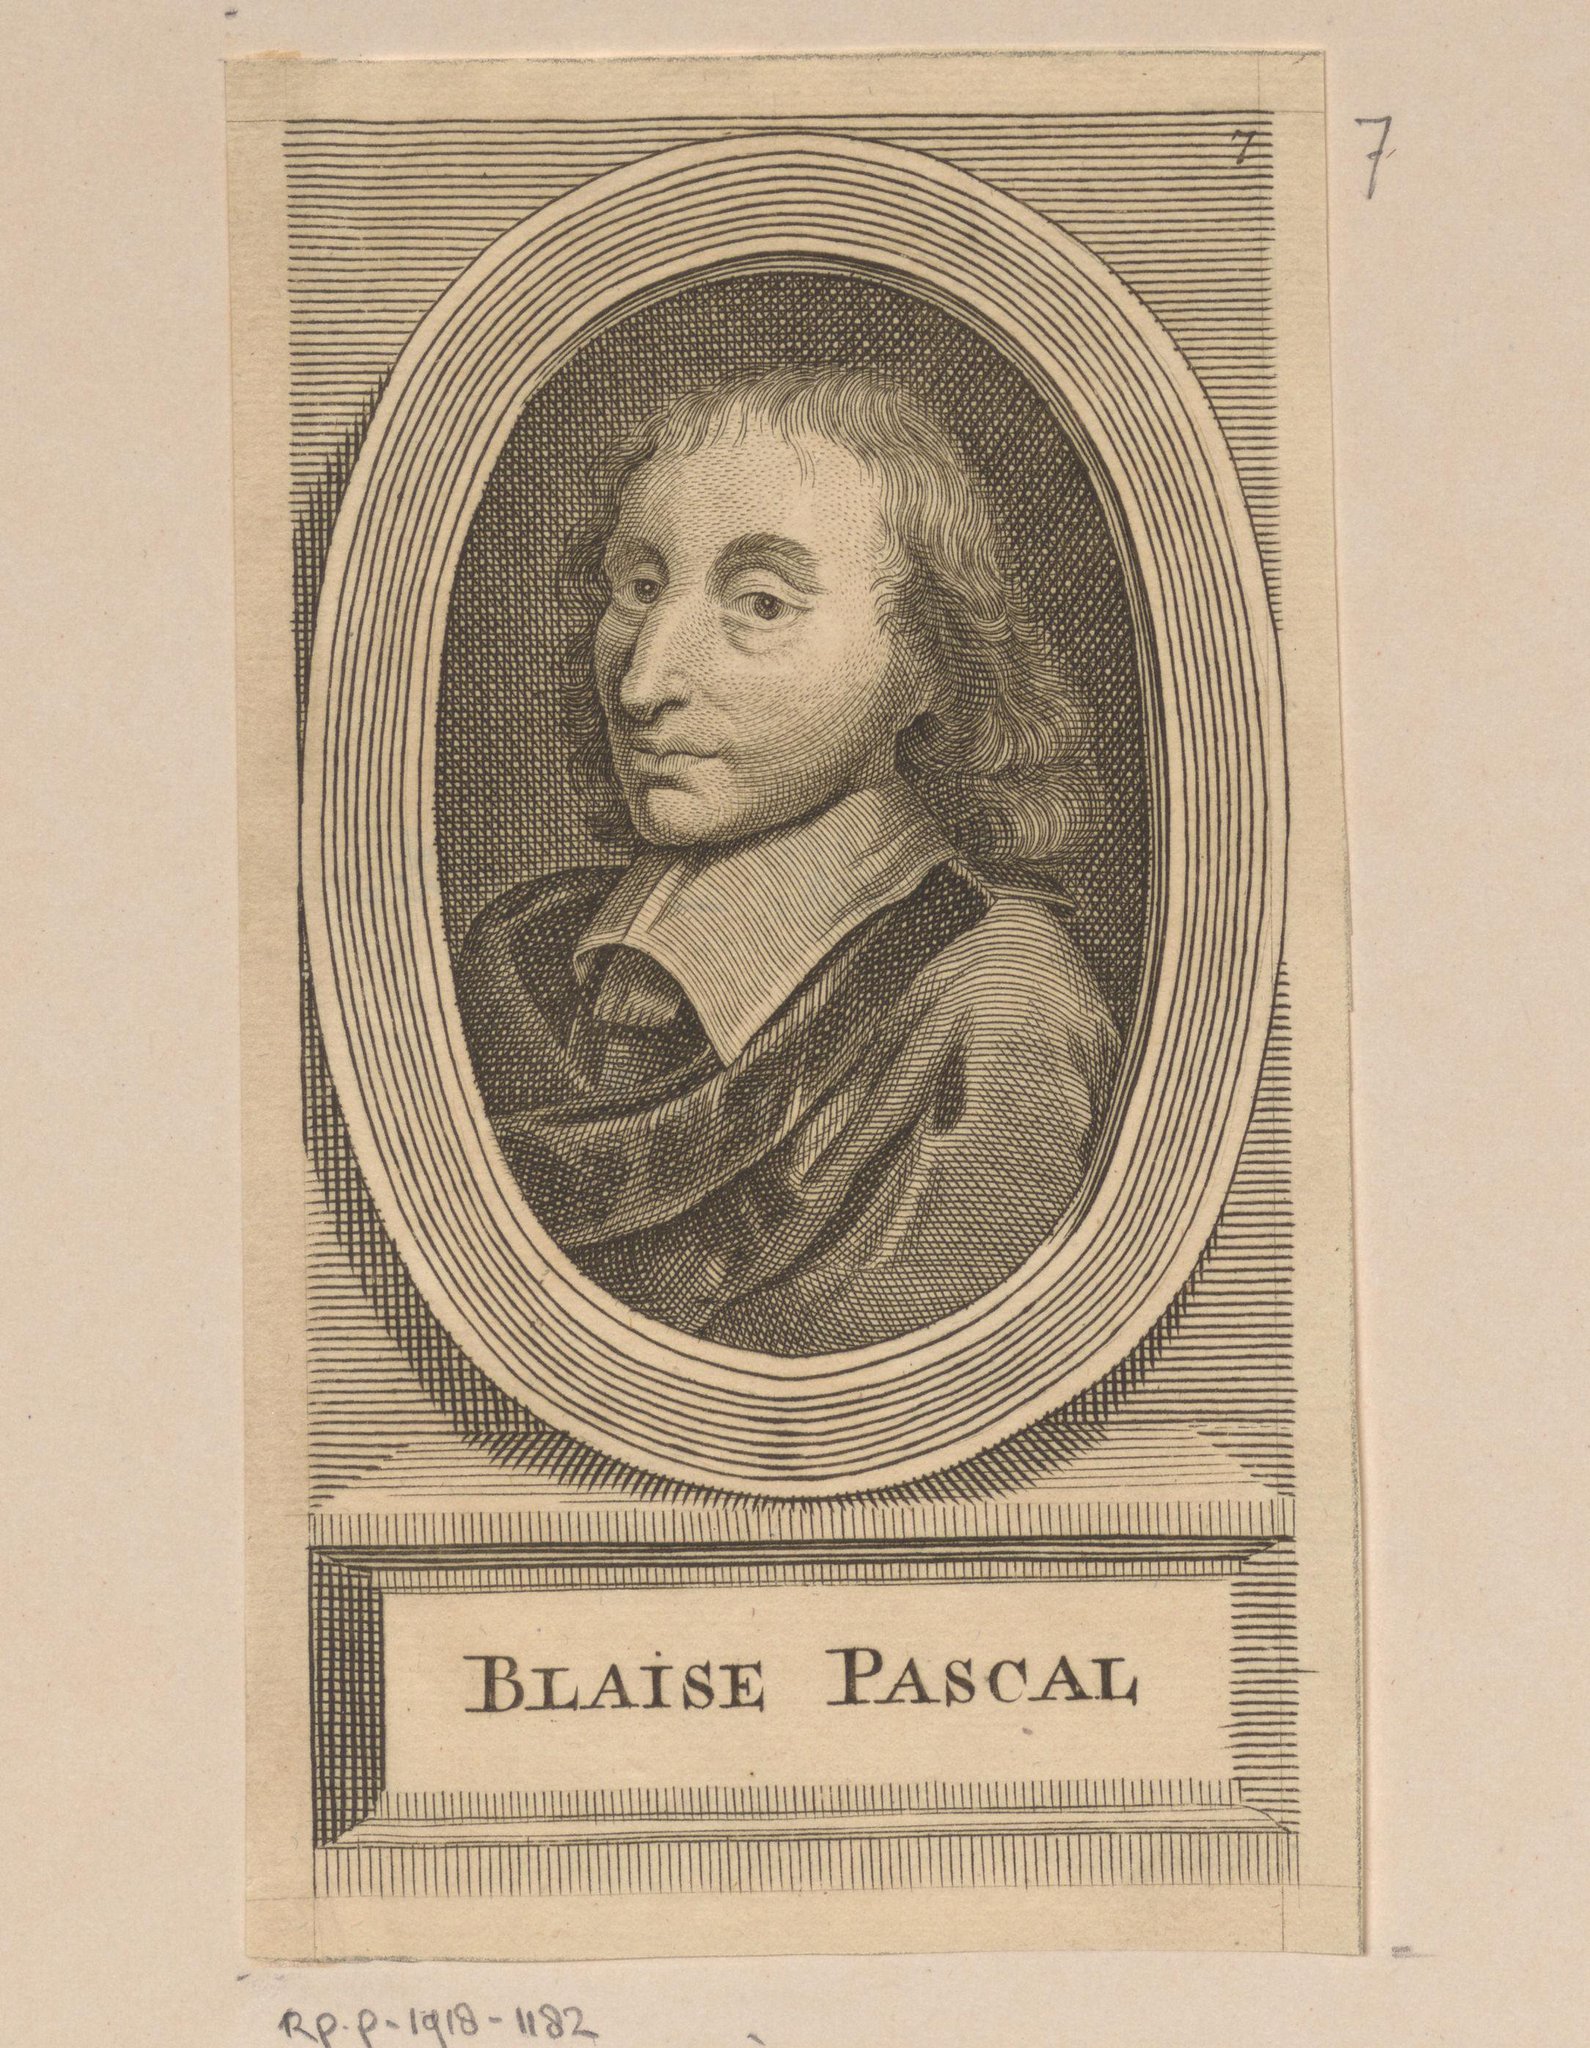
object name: book illustration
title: Portret van Blaise Pascal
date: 1700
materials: paper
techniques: engraving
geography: amsterdam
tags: adult man, historical persons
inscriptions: collector's mark: Lugt 2233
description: Prent uit: Gerberon, Gabriel. Histoire Generale du Jansenisme, Contenant Ce qui s'est passé en France (...). Amsterdam: Jean Louis Delorme, 1700, dl. 2.